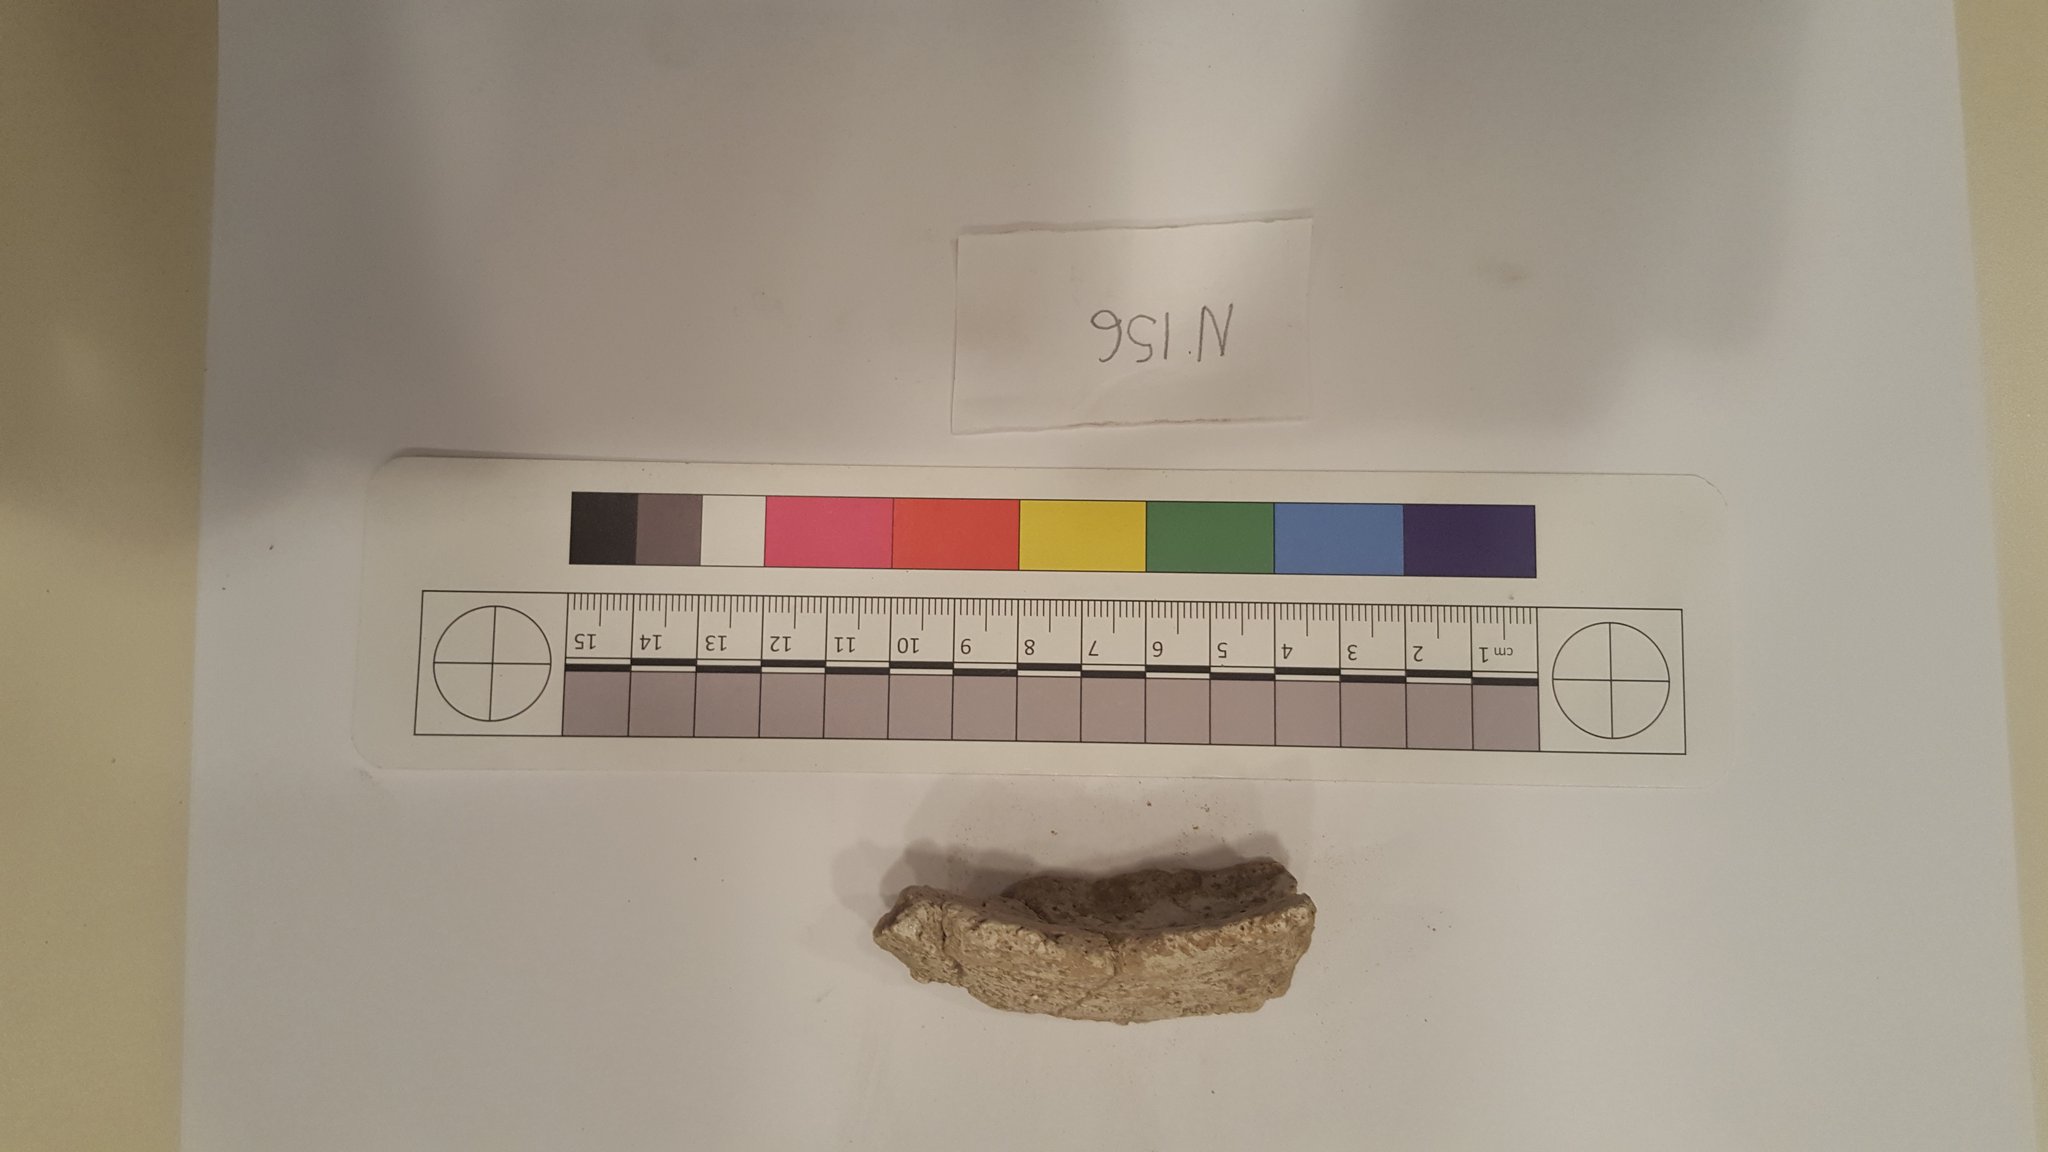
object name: fragment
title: Stucco Fragment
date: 701-1200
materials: plaster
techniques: carving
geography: iran